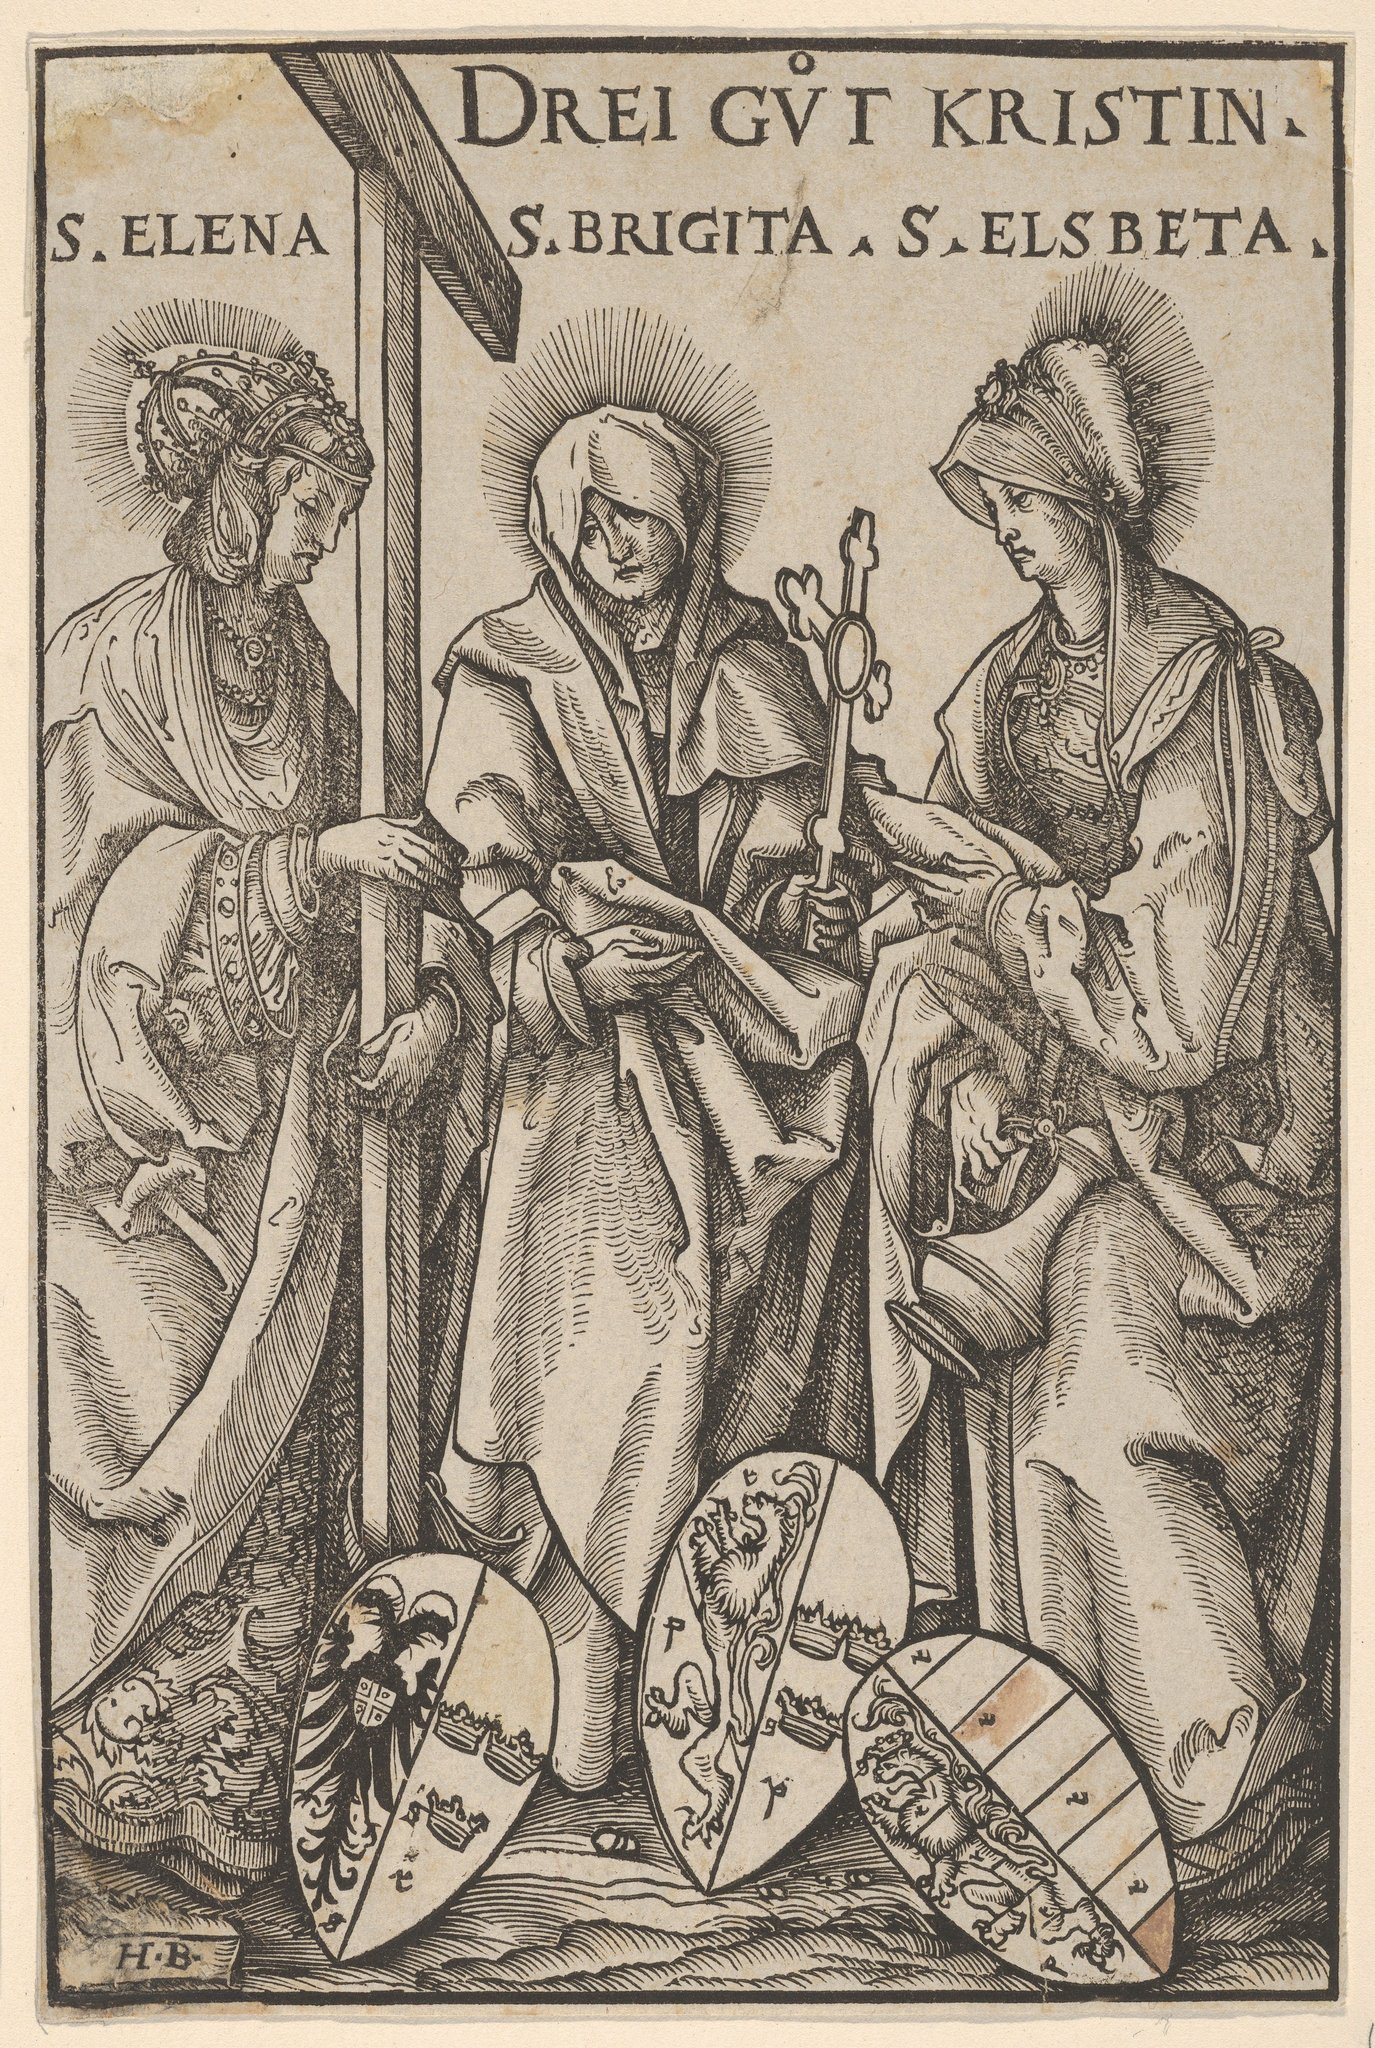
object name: print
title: The Three Christian Heroines (Drei Gut Kristin), from "Heroes and Heroines"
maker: hans burgkmair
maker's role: artist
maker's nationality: german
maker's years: 1473-1531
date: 1516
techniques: woodcut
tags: cross,saints,coat of arms